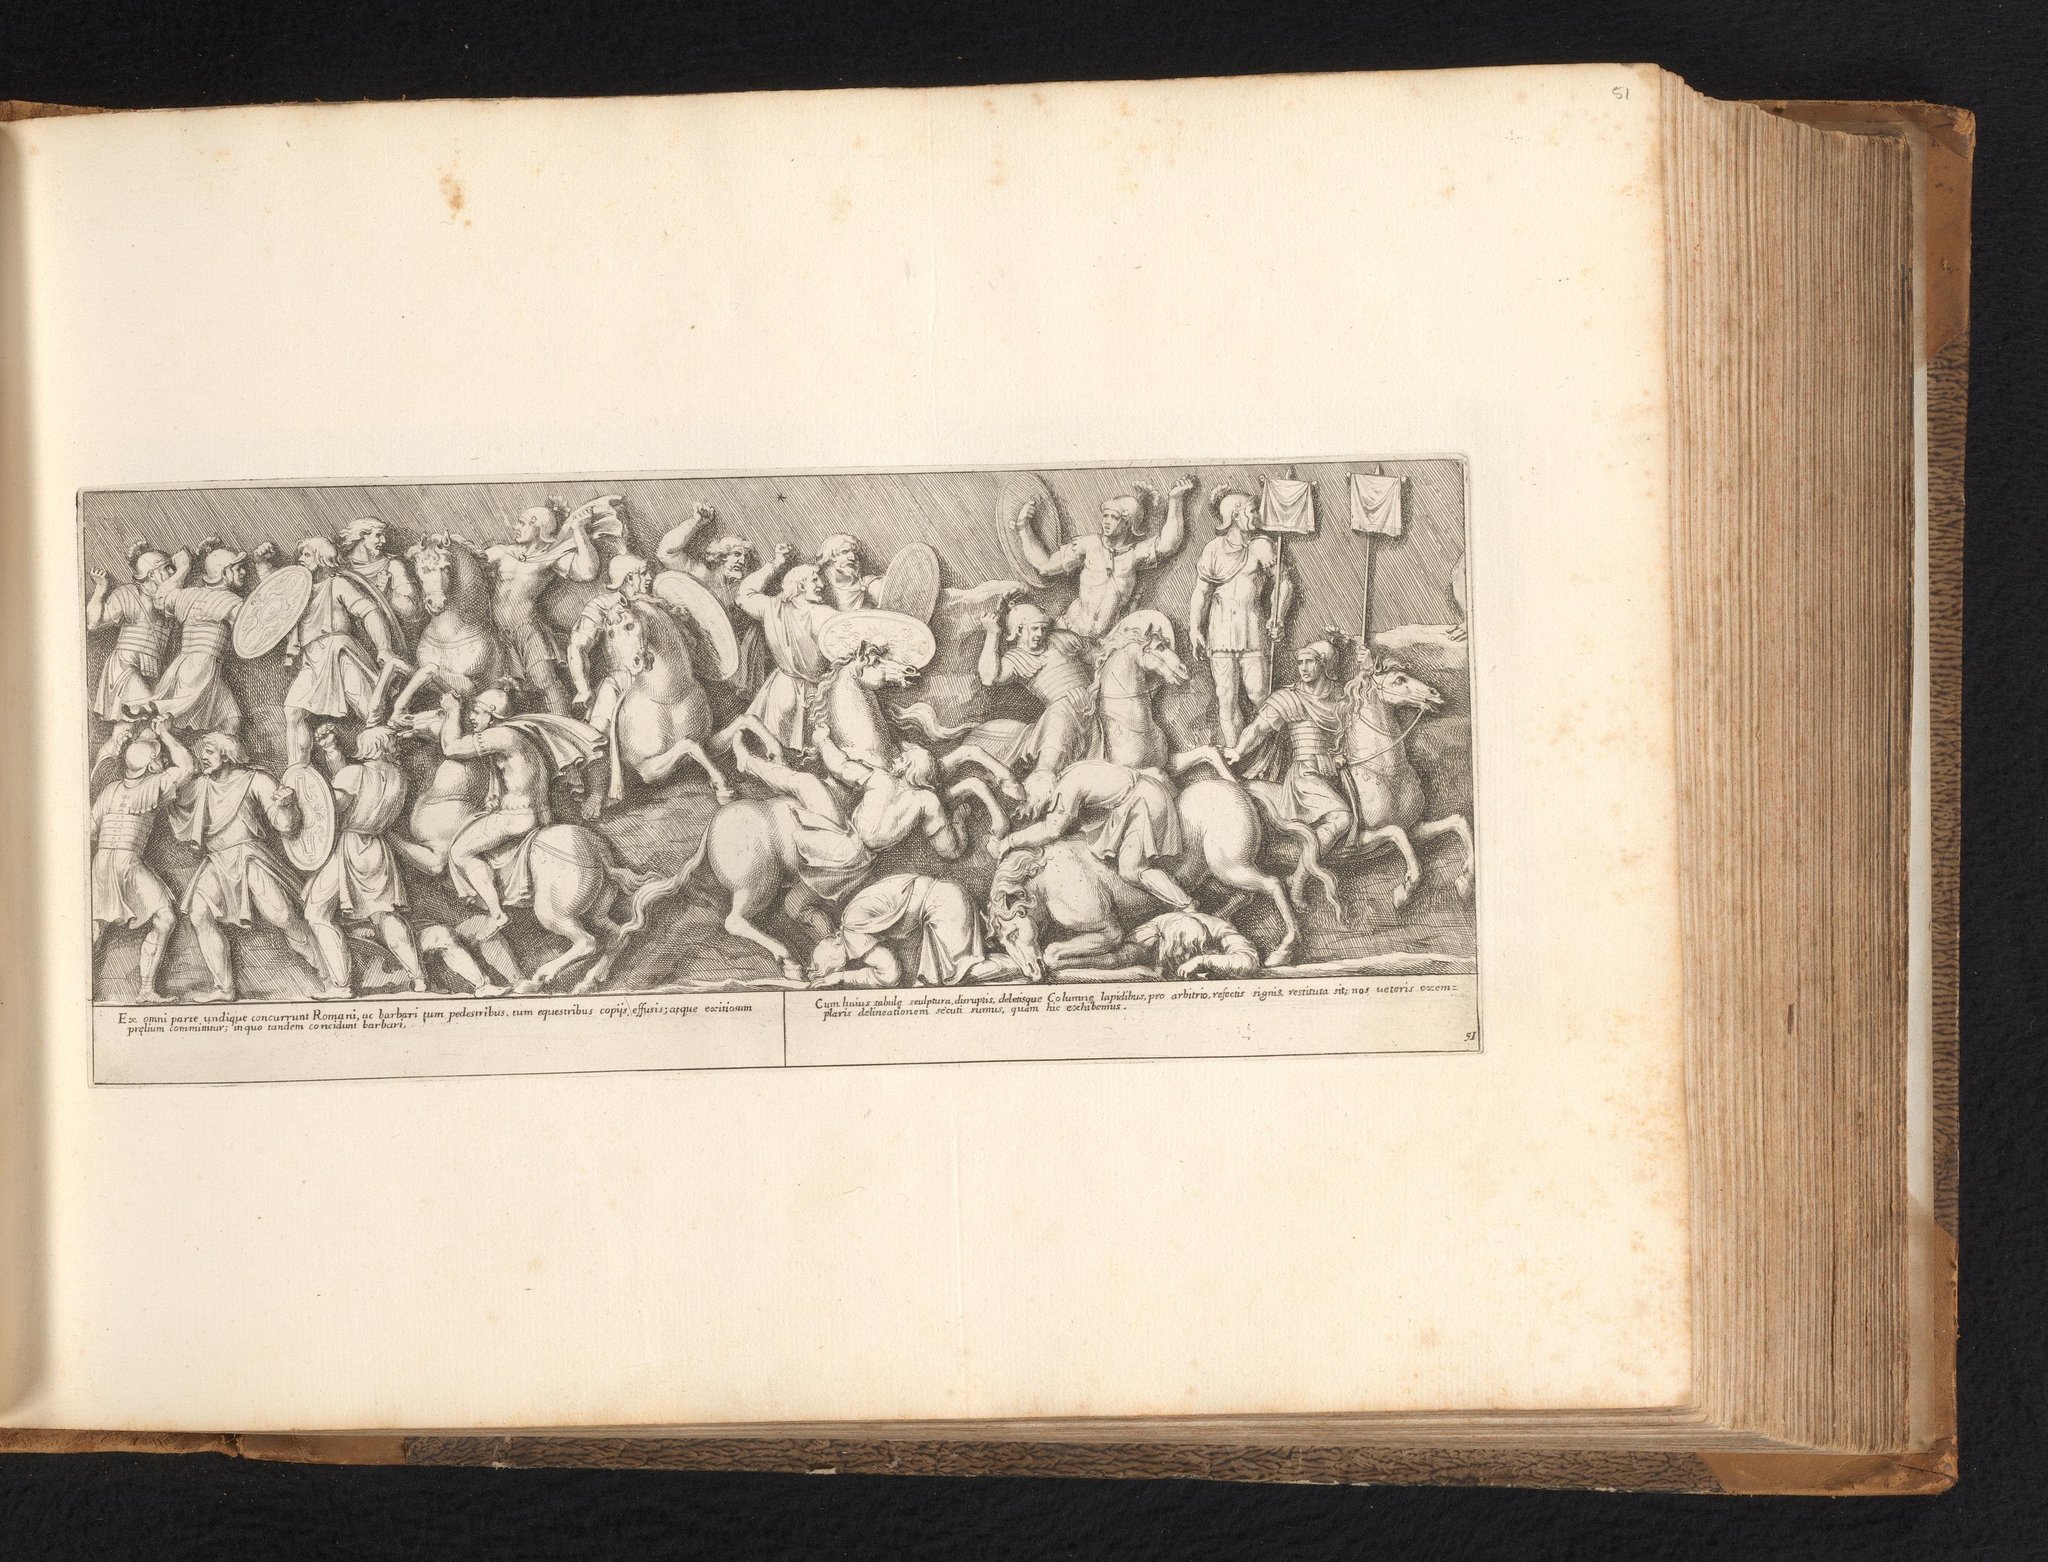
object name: album leaf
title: Detail van het fries op de Zuil van Marcus Aurelius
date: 1672-1675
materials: paper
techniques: etching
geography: rome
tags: triumphal column with helical friezes, piece of sculpture, reproduction of a piece of sculpture, the soldier; the soldier's life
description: Detail van het spiraalvormige gebeeldhouwde fries op de Zuil van Marcus Aurelius te Rome. Het fries toont de oorlog tussen het Romeinse leger van keizer Marcus Aurelius en de Germaanse stammen der Marcomannen en Quaden en de oorlog tegen de Sarmaten die vanuit het huidige Iran Hongarije waren binnengevallen. Tekst in de ondermarge. Prent maakt deel uit van een album.